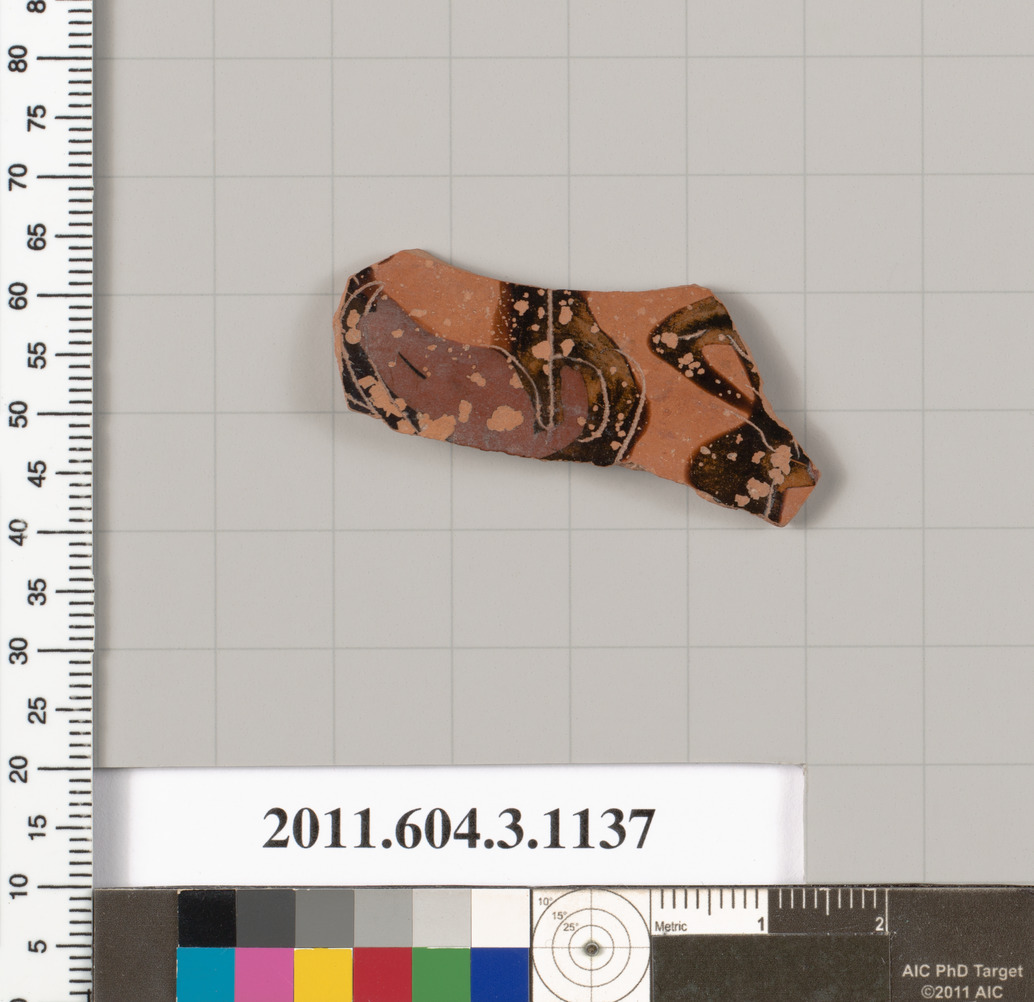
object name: mastoid or kyathos fragment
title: Terracotta fragment of a mastoid (drinking cup with narrow base) or a kyathos (cup-shaped ladle)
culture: greek, attic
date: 534-468 BCE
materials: terracotta